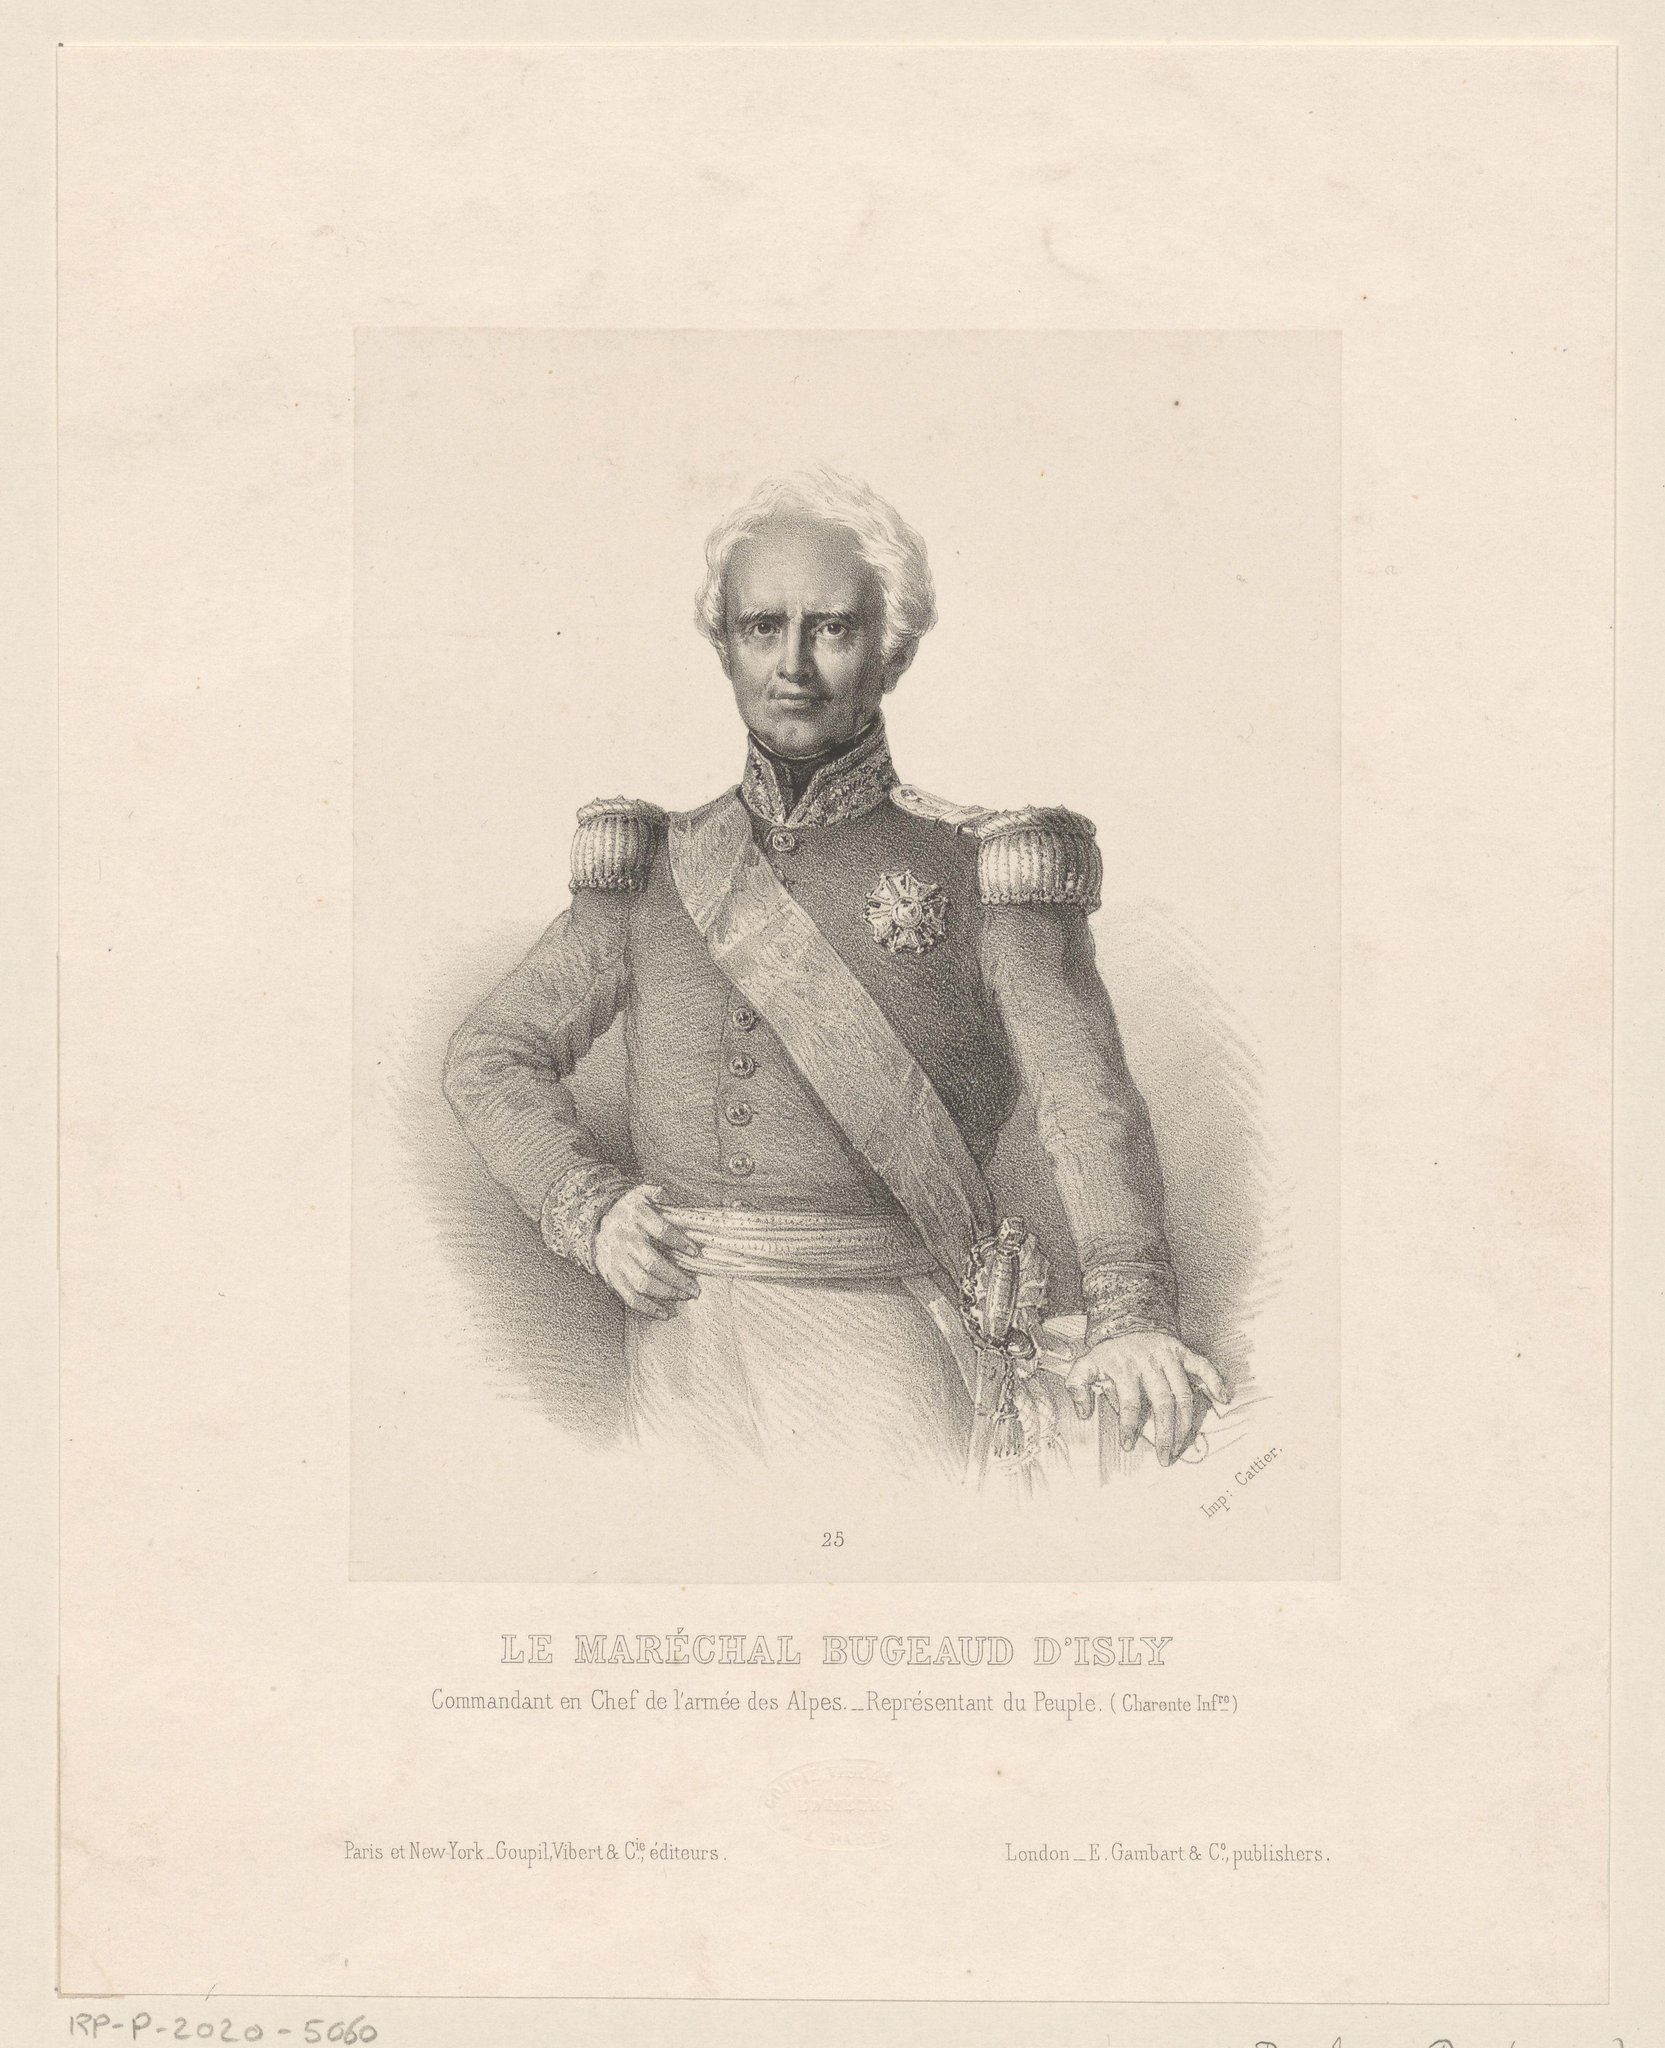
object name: print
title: Portret van Thomas-Robert Bugeaud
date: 1841-1850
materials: paper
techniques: lithograph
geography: new york city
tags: paris, commander-in-chief, general, marshal, historical persons